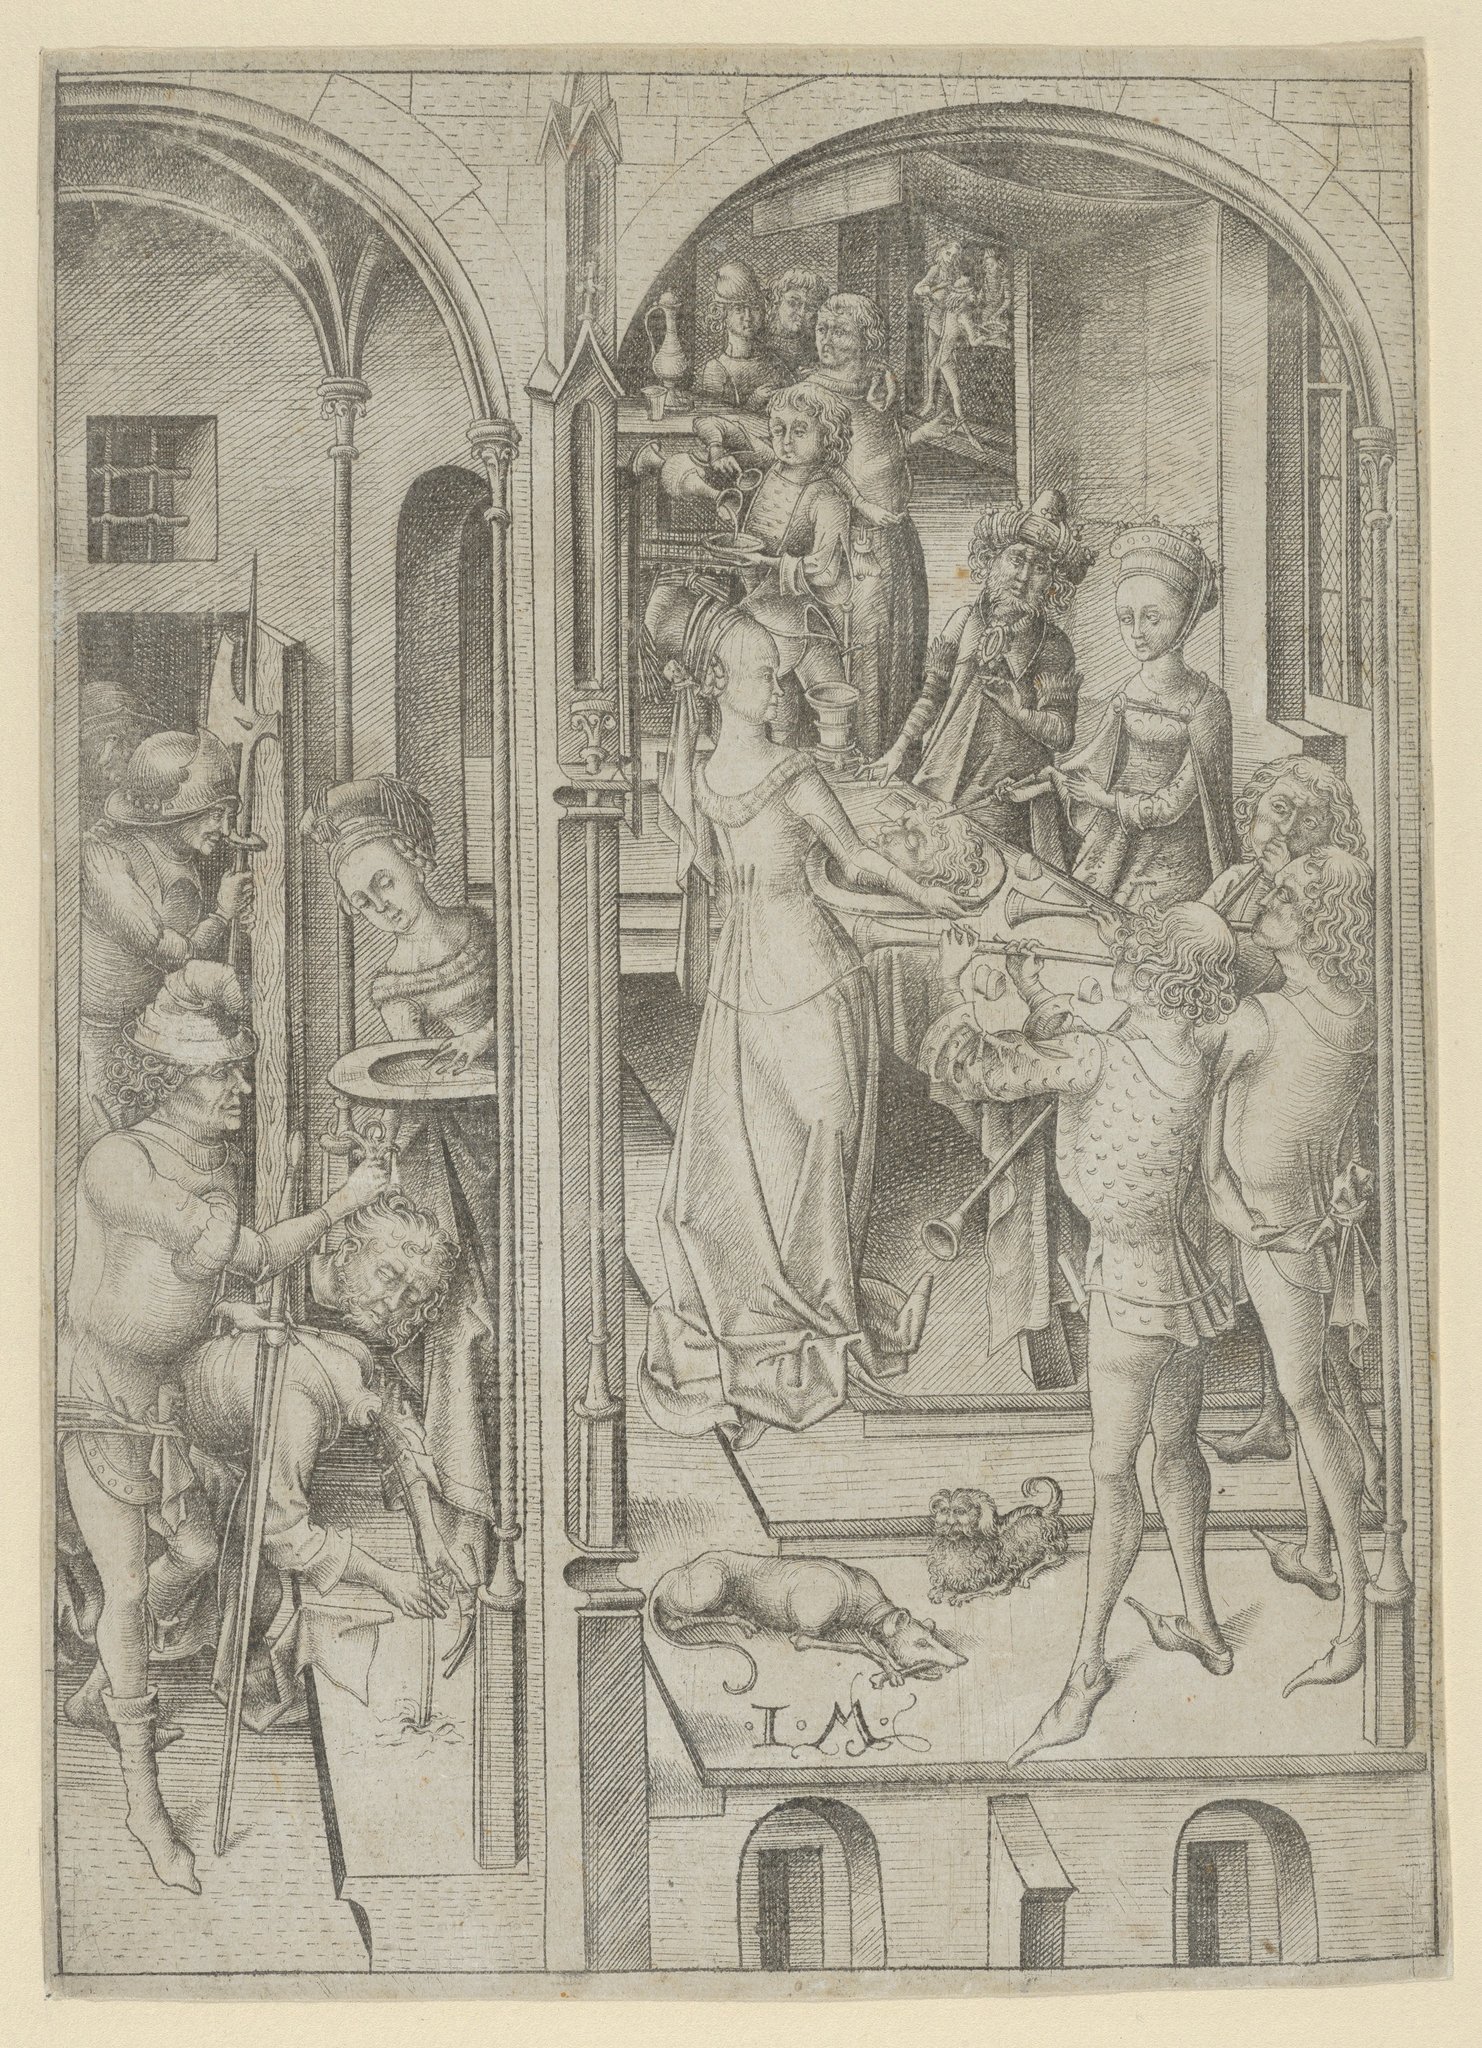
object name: print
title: The Beheading of St. John the Baptist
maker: israhel van meckenem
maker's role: artist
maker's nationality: german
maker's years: 1435-1503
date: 1450-1503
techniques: engraving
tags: saint john the baptist,execution